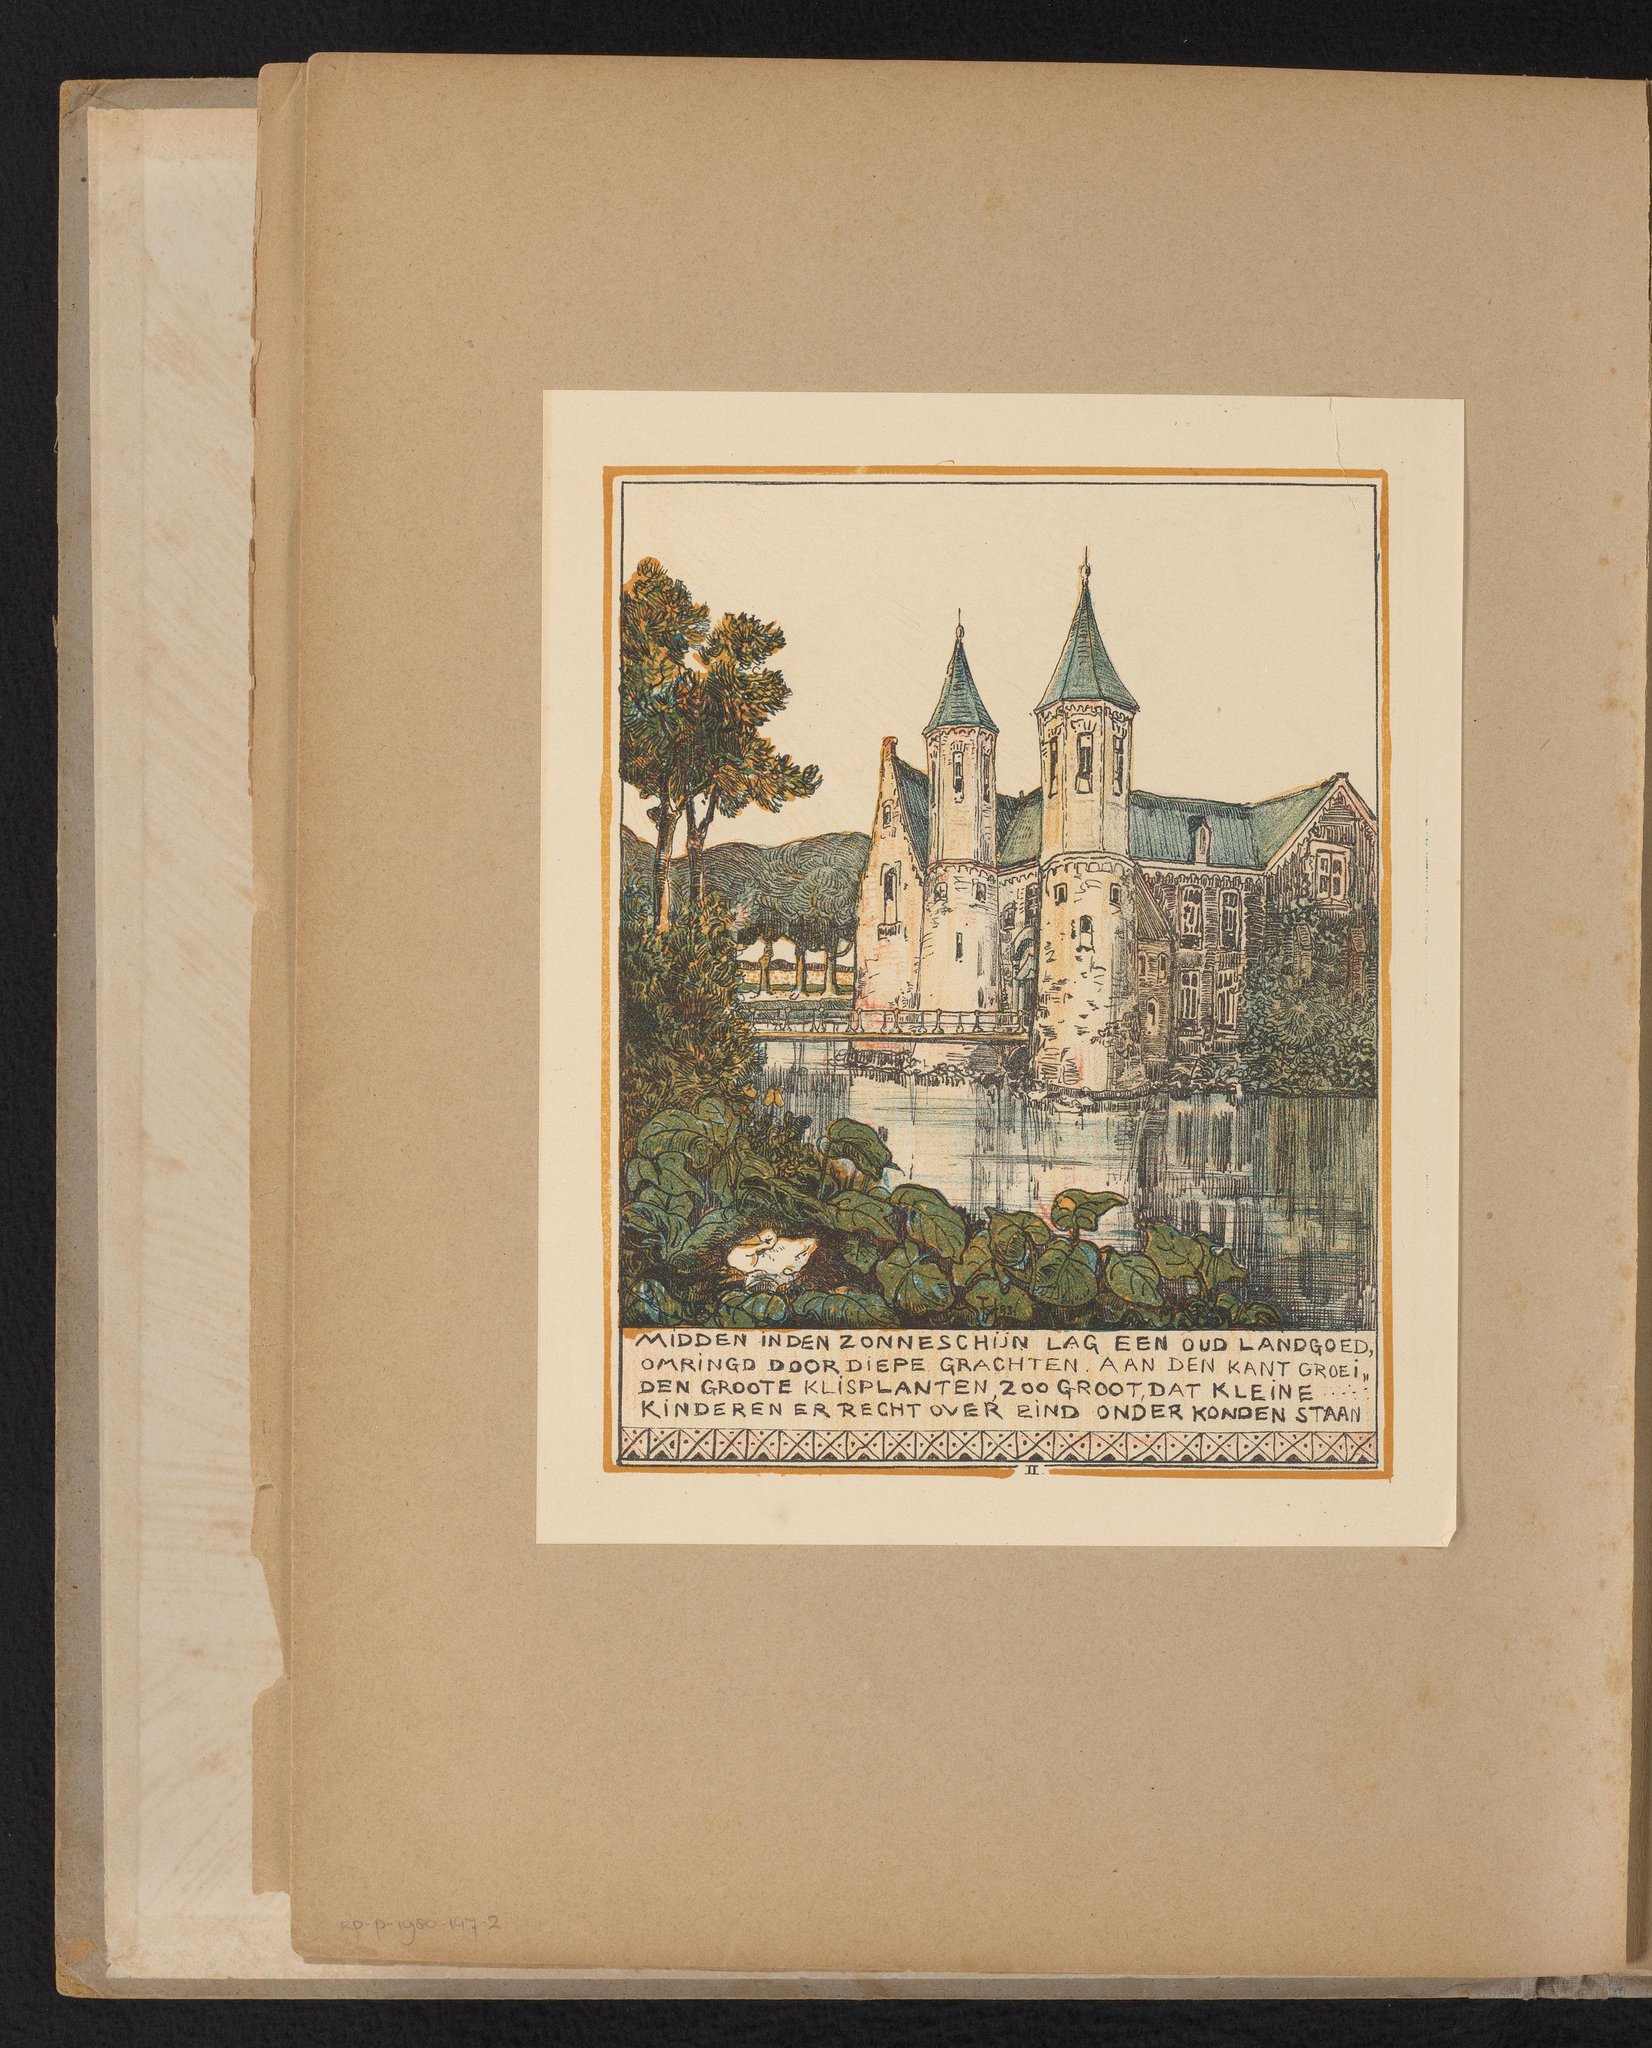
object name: print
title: Broedende eend bij de slotgracht van een kasteel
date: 1893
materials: paper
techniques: lithograph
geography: the hague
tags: moat ~ fortified city, landscape with tower or castle, water-birds: duck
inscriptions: date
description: Deze prent maakt deel uit van een album.